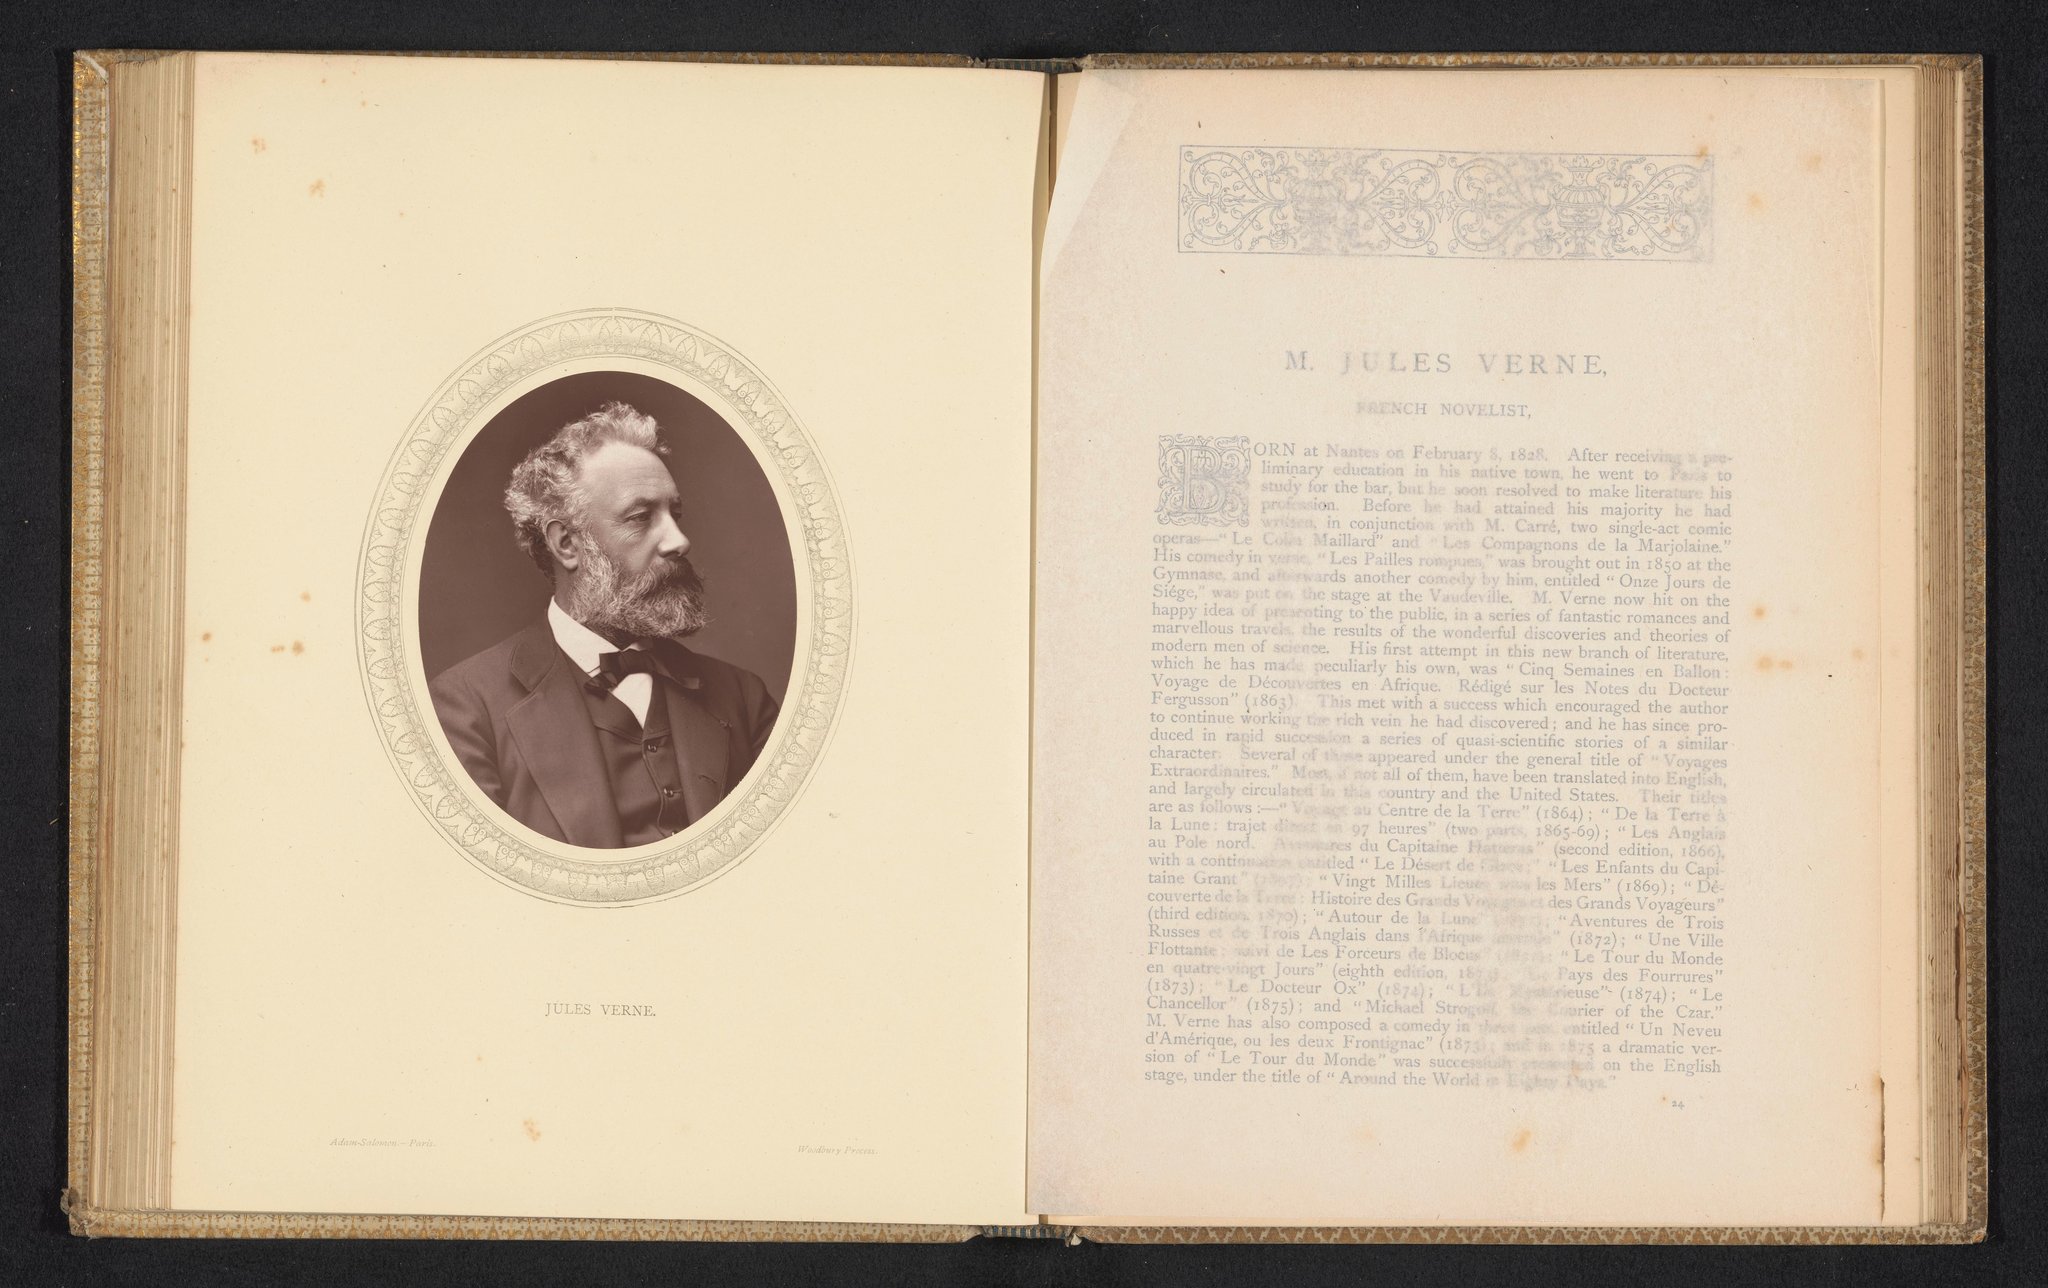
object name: photomechanical print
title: Jules Verne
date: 1871-1876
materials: paper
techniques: woodburytype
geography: france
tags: portrait of a writer, historical persons (portraits and scenes from the life) (+ (full) bust portrait)